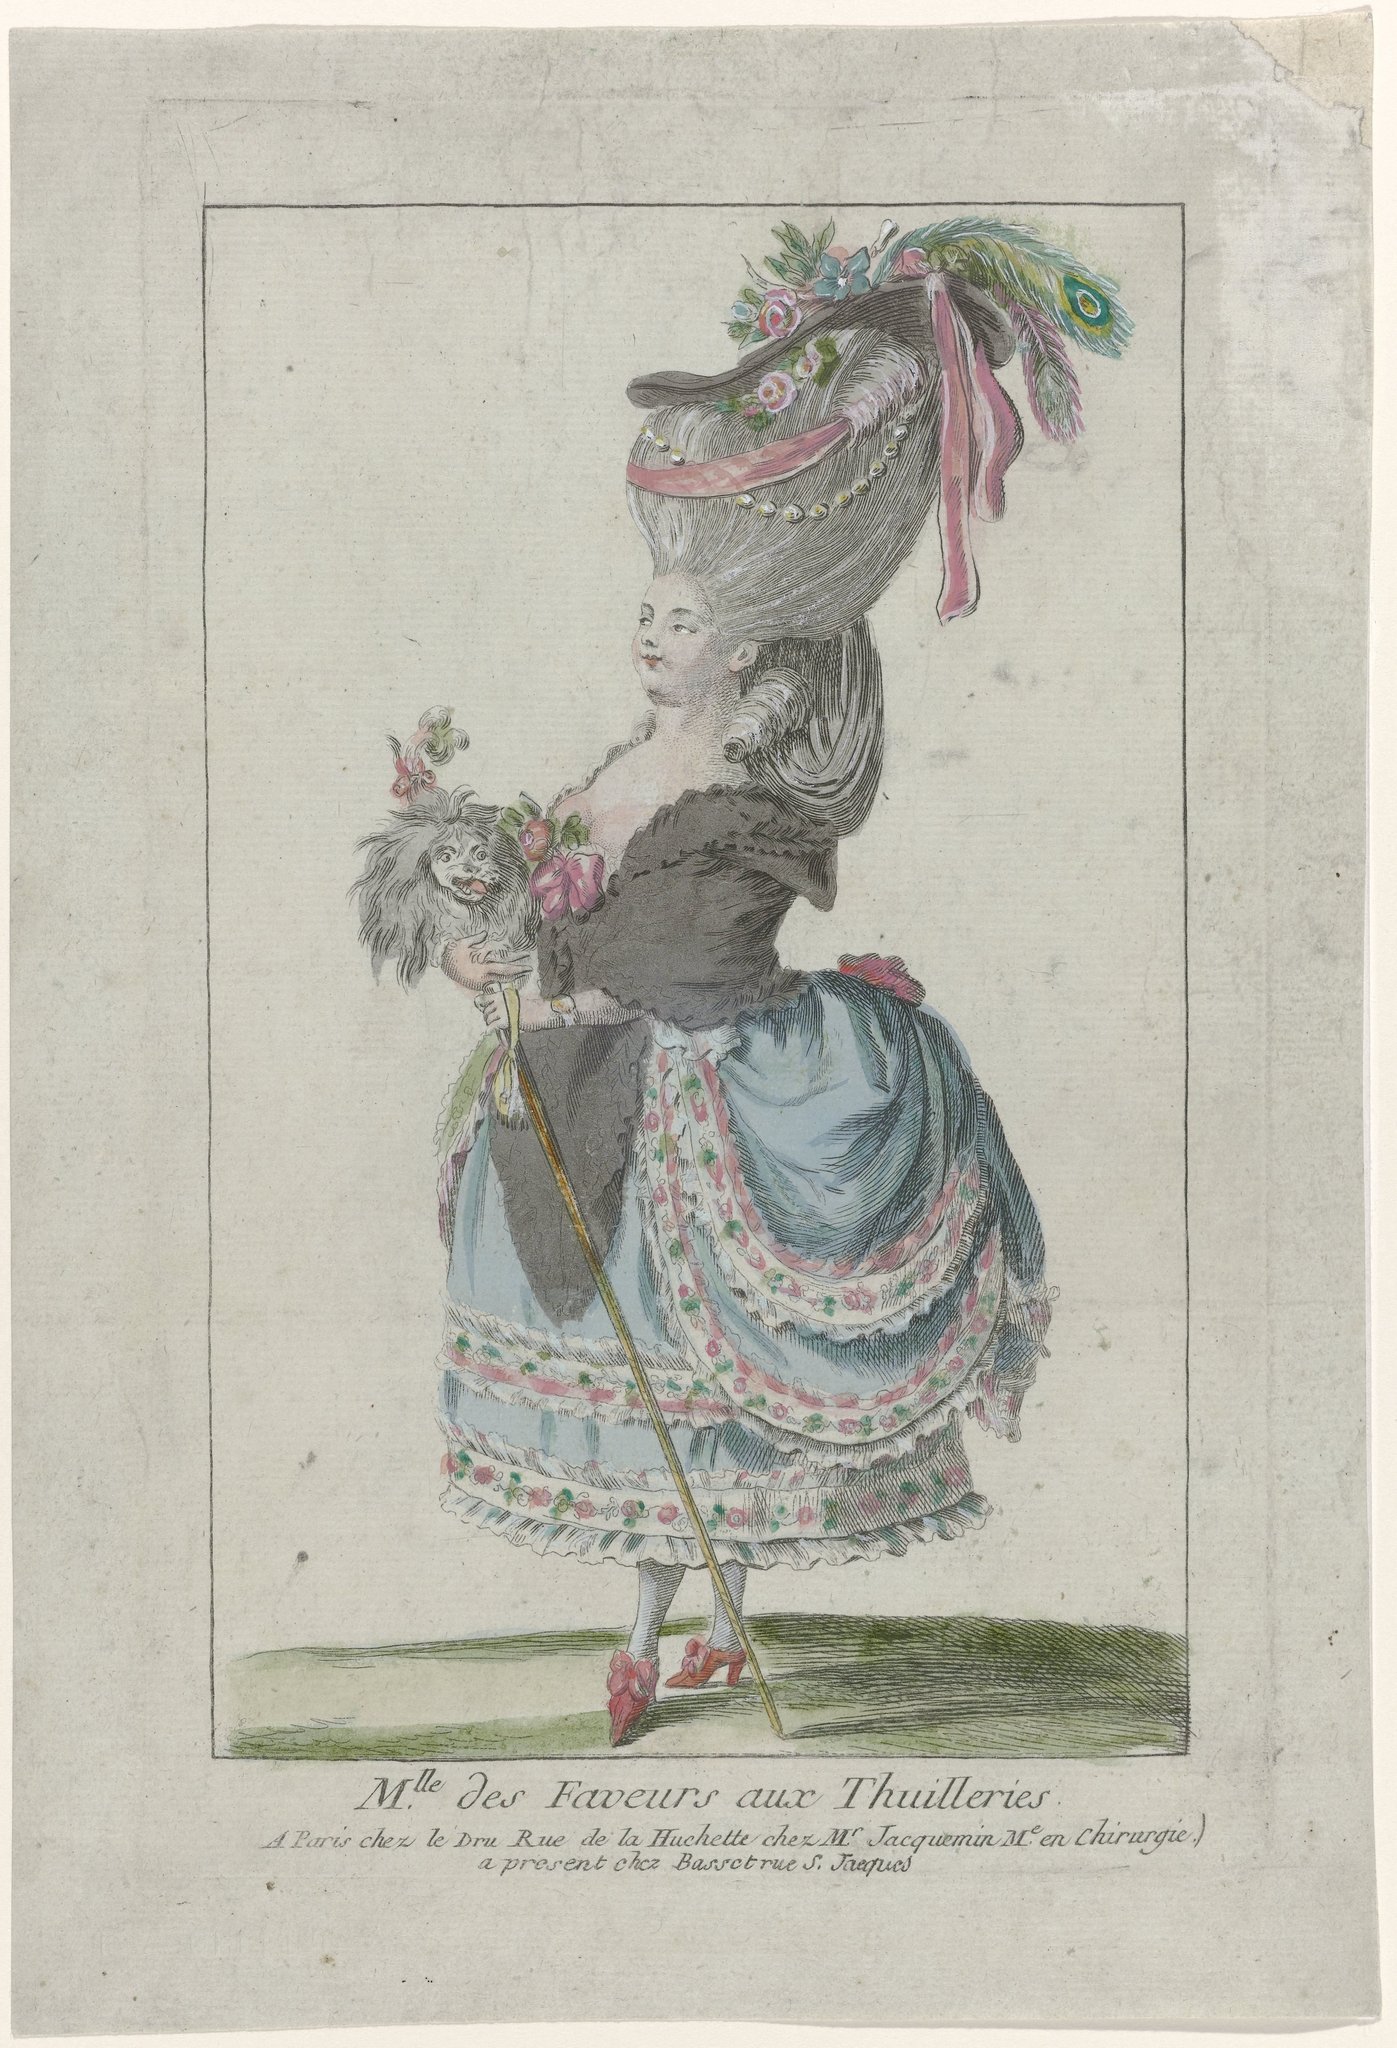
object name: fashion print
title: Suite consacrée aux élégantes et petits maîtres, 1778-1785, (13) : M.lle des Faveurs aux Thuilleries (...)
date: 1778-1785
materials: paper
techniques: engraving, hand coloring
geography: paris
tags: clothing for the upper part of the body (+ women's clothes), walking-stick, staff, cane (+ women's clothes), clothing for the upper part of the body (mantelet) (+ women's clothes), styles of hairdress - aa - ~ women, fashion plates, head-gear: hat (+ women's clothes), shoes, sandals (+ women's clothes), skirt (+ women's clothes), dog, dress, gown: robe à la polonaise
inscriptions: caption: ‘M.lle des Faveurs aux Thuilleries.’, address: ‘A Paris chez le Dru Rue de la Huchette chez Mr.Jacquemin Me. en chirurgie.a present chez Basset rue S. Jacques.’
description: Volgens het onderschrift wandelt deze voluptueuze vrouw, ofwel Mlle des Faveurs, met een hondje op de arm in de Tuilerieën. Zij draagt een 'robe à la Polonaise' gegarneerd met banden met bloemmotief en gerimpelde stroken stof. Mantelet (kleine schoudermantel) met capuchon. Op het hoge kapsel een hoed versierd met lint, parels, bloemen en pauwenveren. Verdere accessoires: armband, wandelstok met lint, schoenen met hakken en strikken. De prent maakt deel uit van een reeks van ca. 12 prenten, uitgegeven door Le Dru, Parijs, 1778-1785.